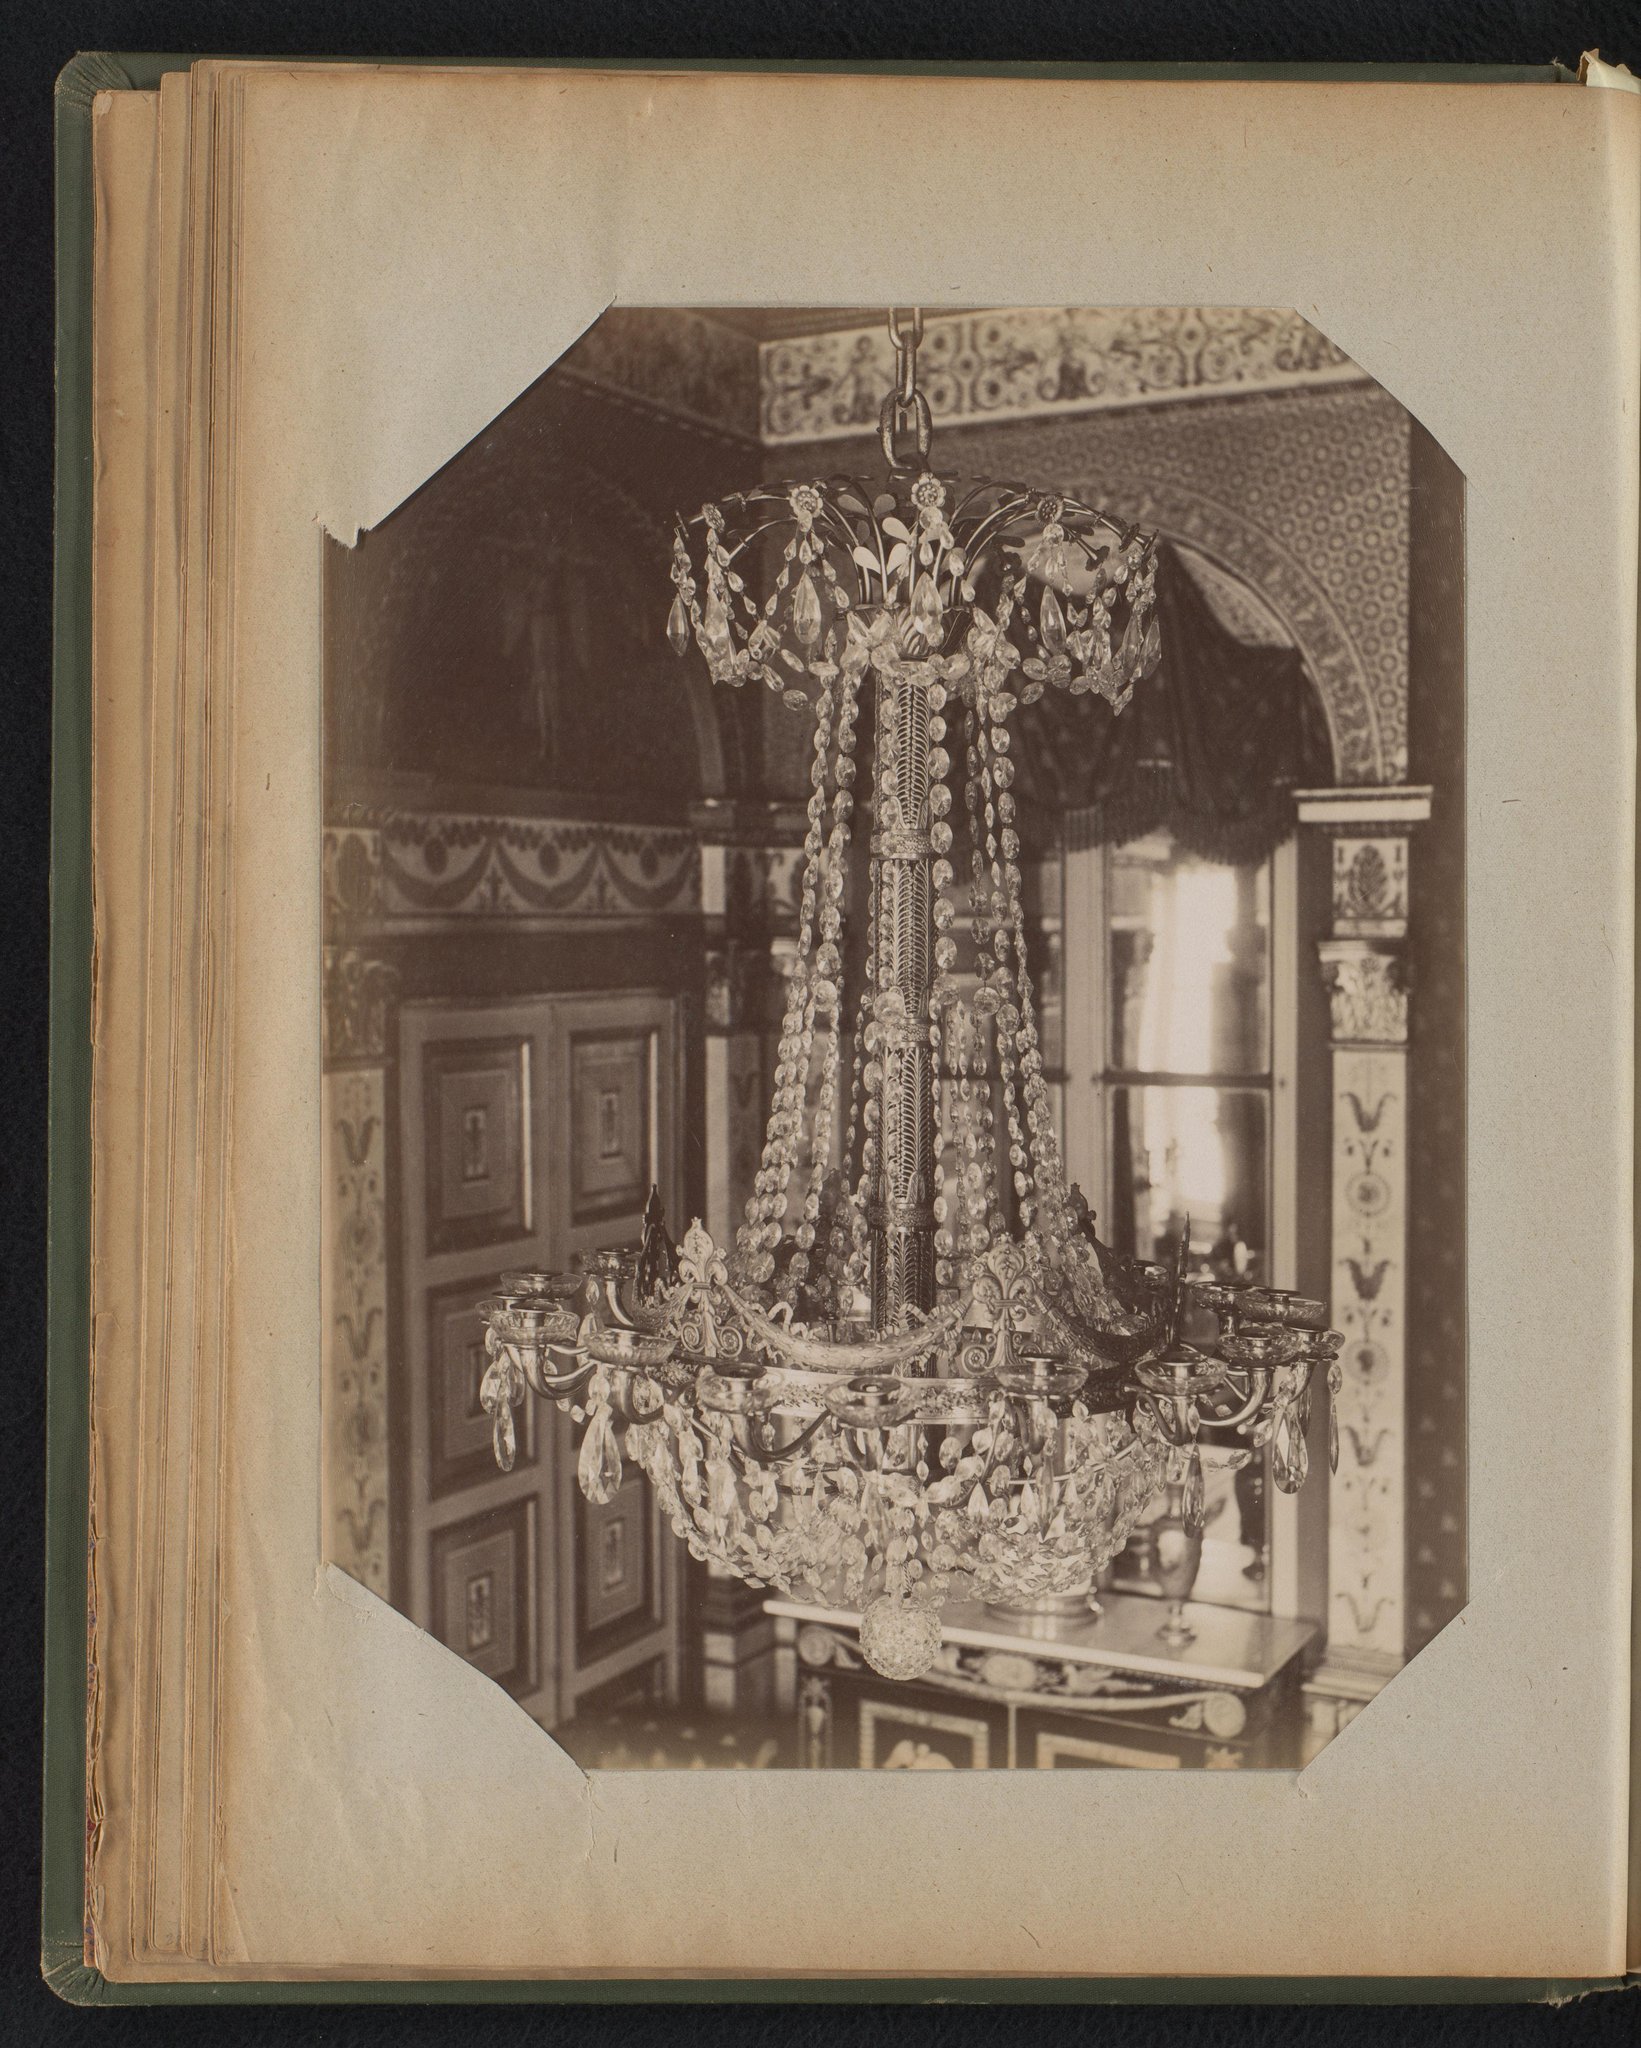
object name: photograph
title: Bronzen kroonluchter met kristallen ornamenten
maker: Anonymous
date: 1860-1900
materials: paper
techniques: albumen print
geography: netherlands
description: De Bronzen midden basis van de kroonluchter is opengewerkt en om de bronzenkandelaars zijn kristallen druppelvangers aangedracht.